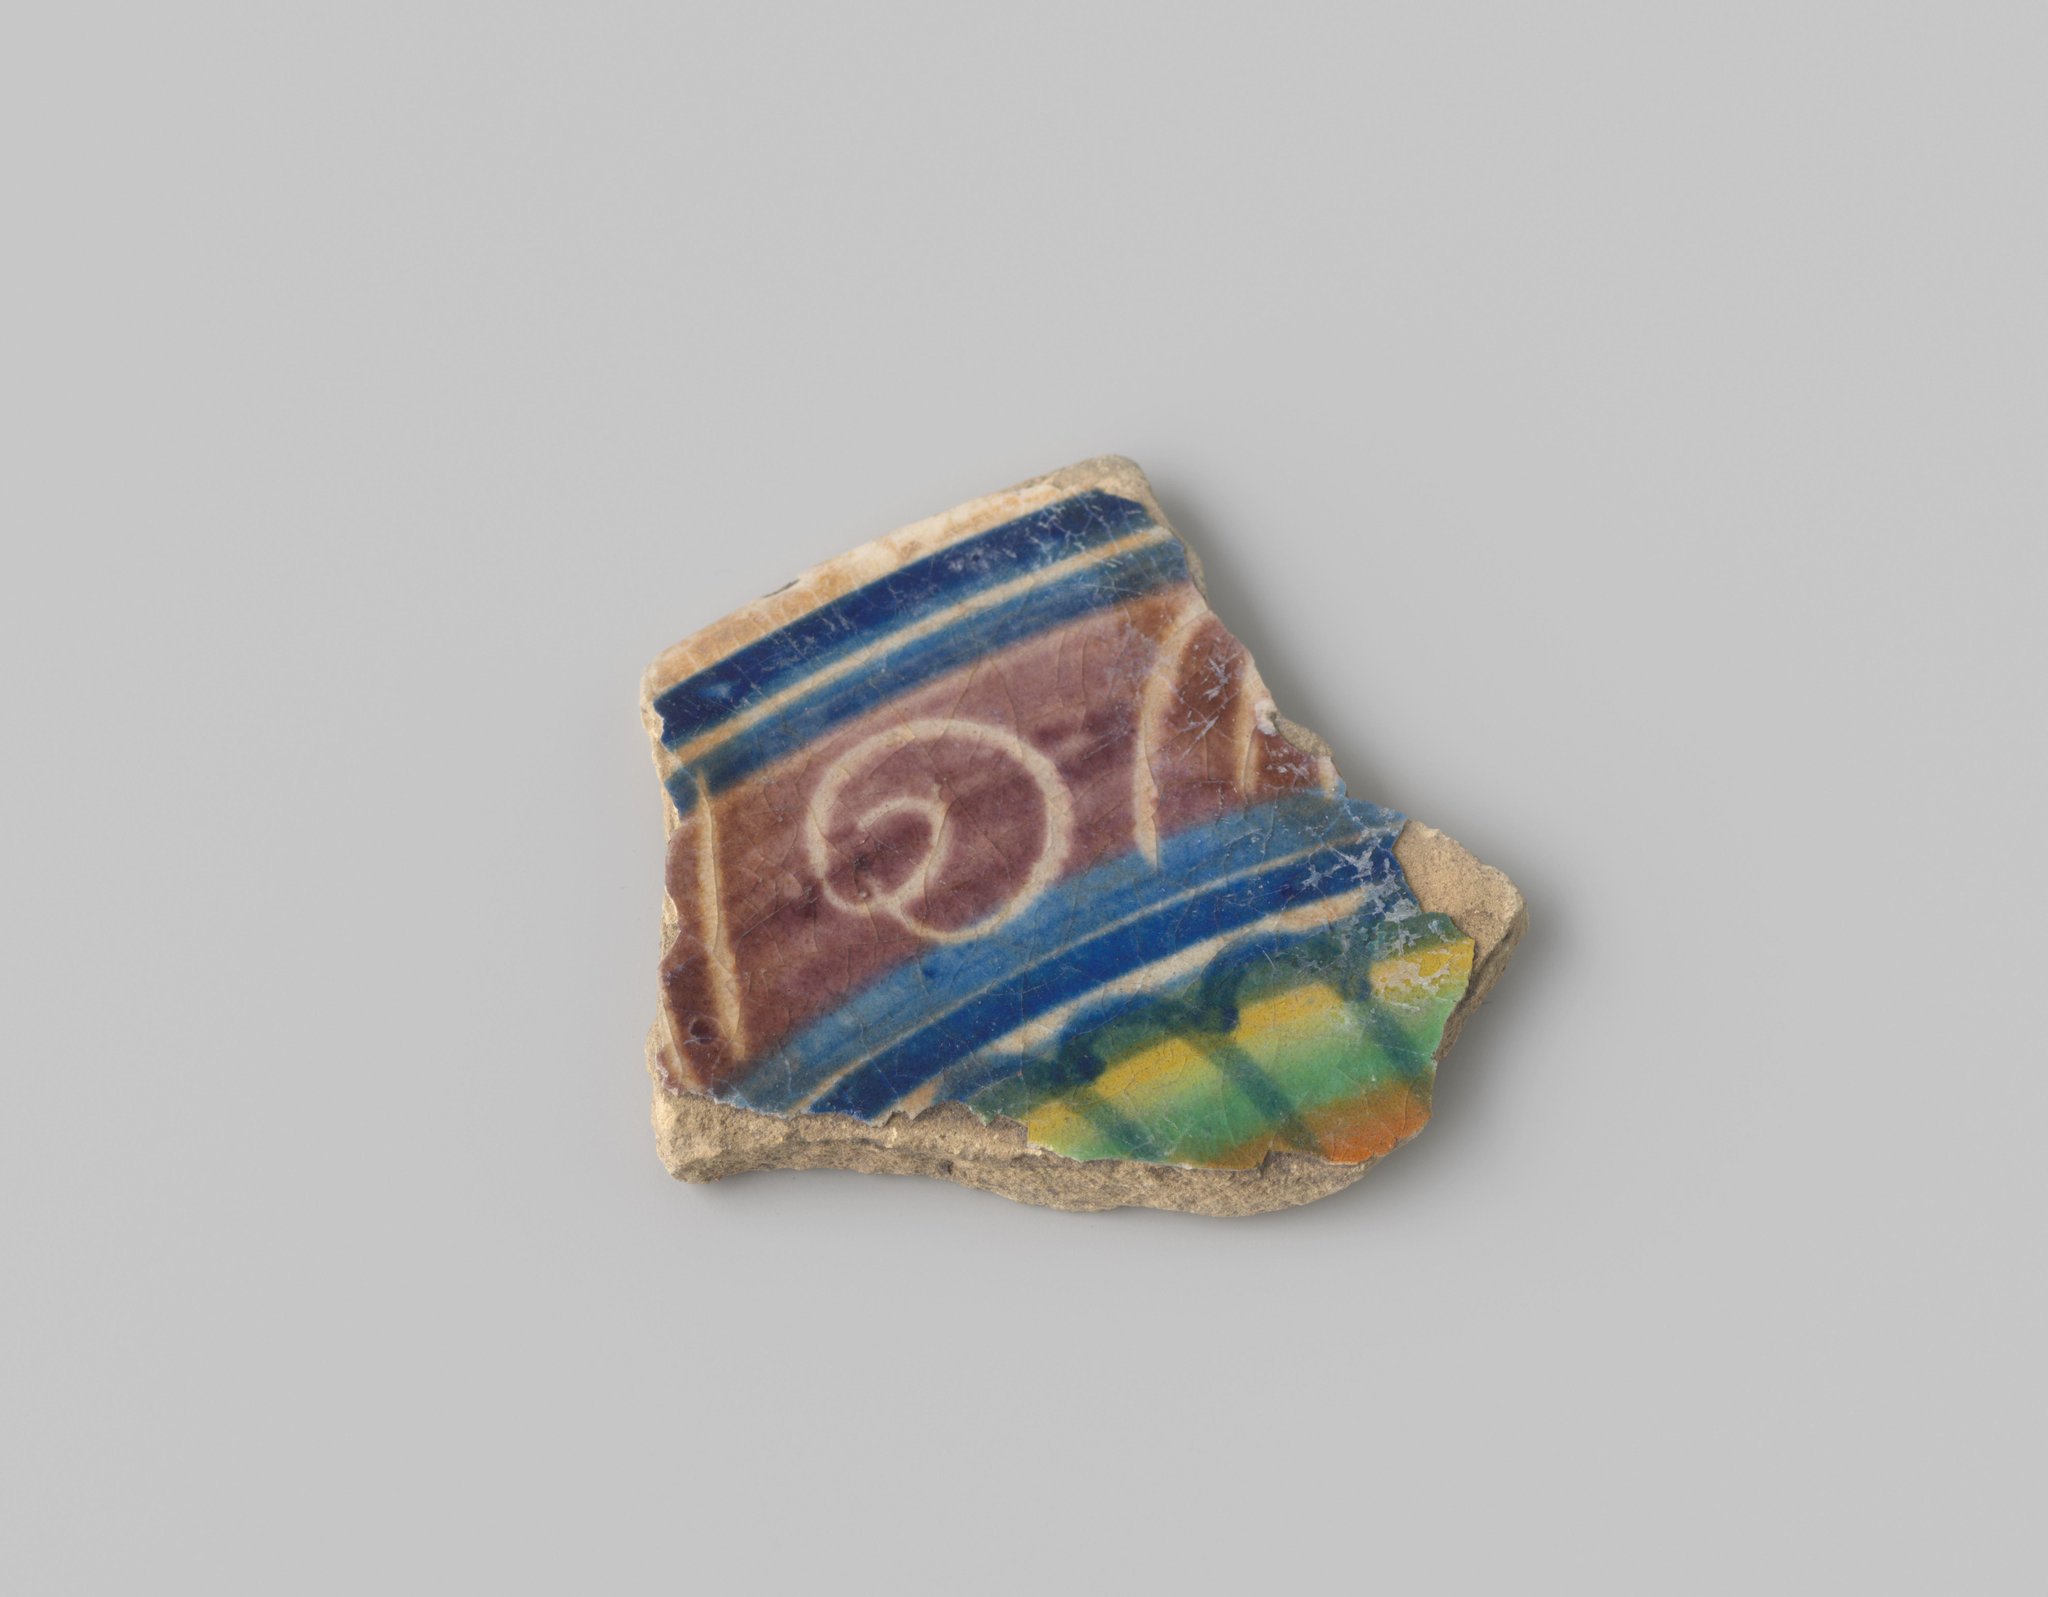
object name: sherd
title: Scherf majolica met veelkleurige decoratie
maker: Anonymous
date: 1500-1699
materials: earthenware, glaze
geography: northern netherlands